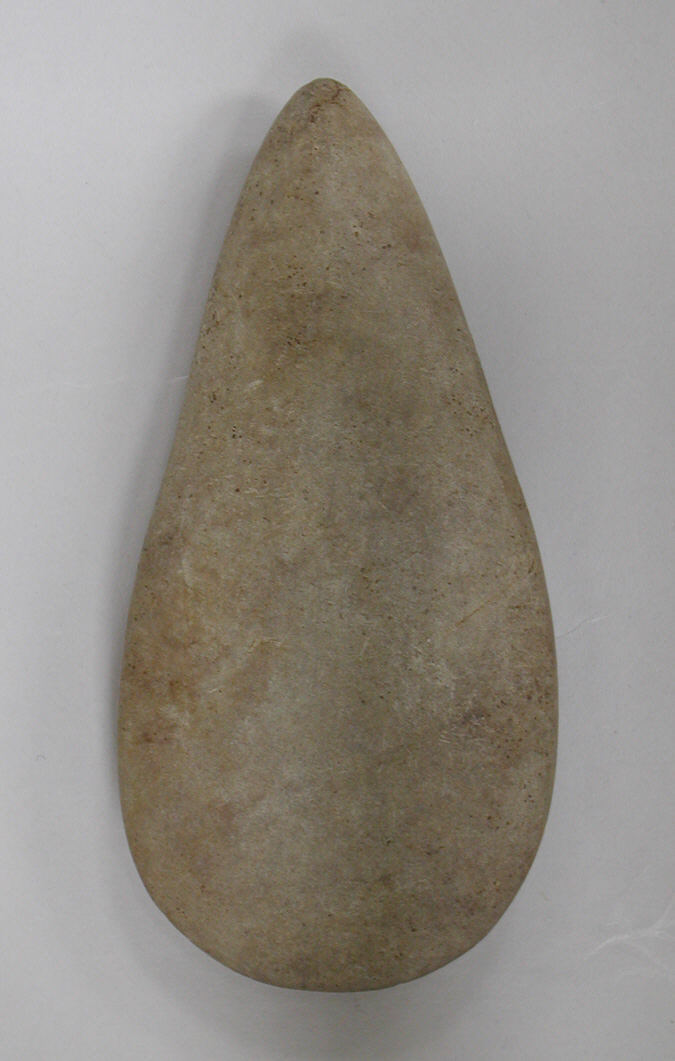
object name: celt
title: Stone Celt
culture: taíno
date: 1501-1600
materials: stone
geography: dominican republic